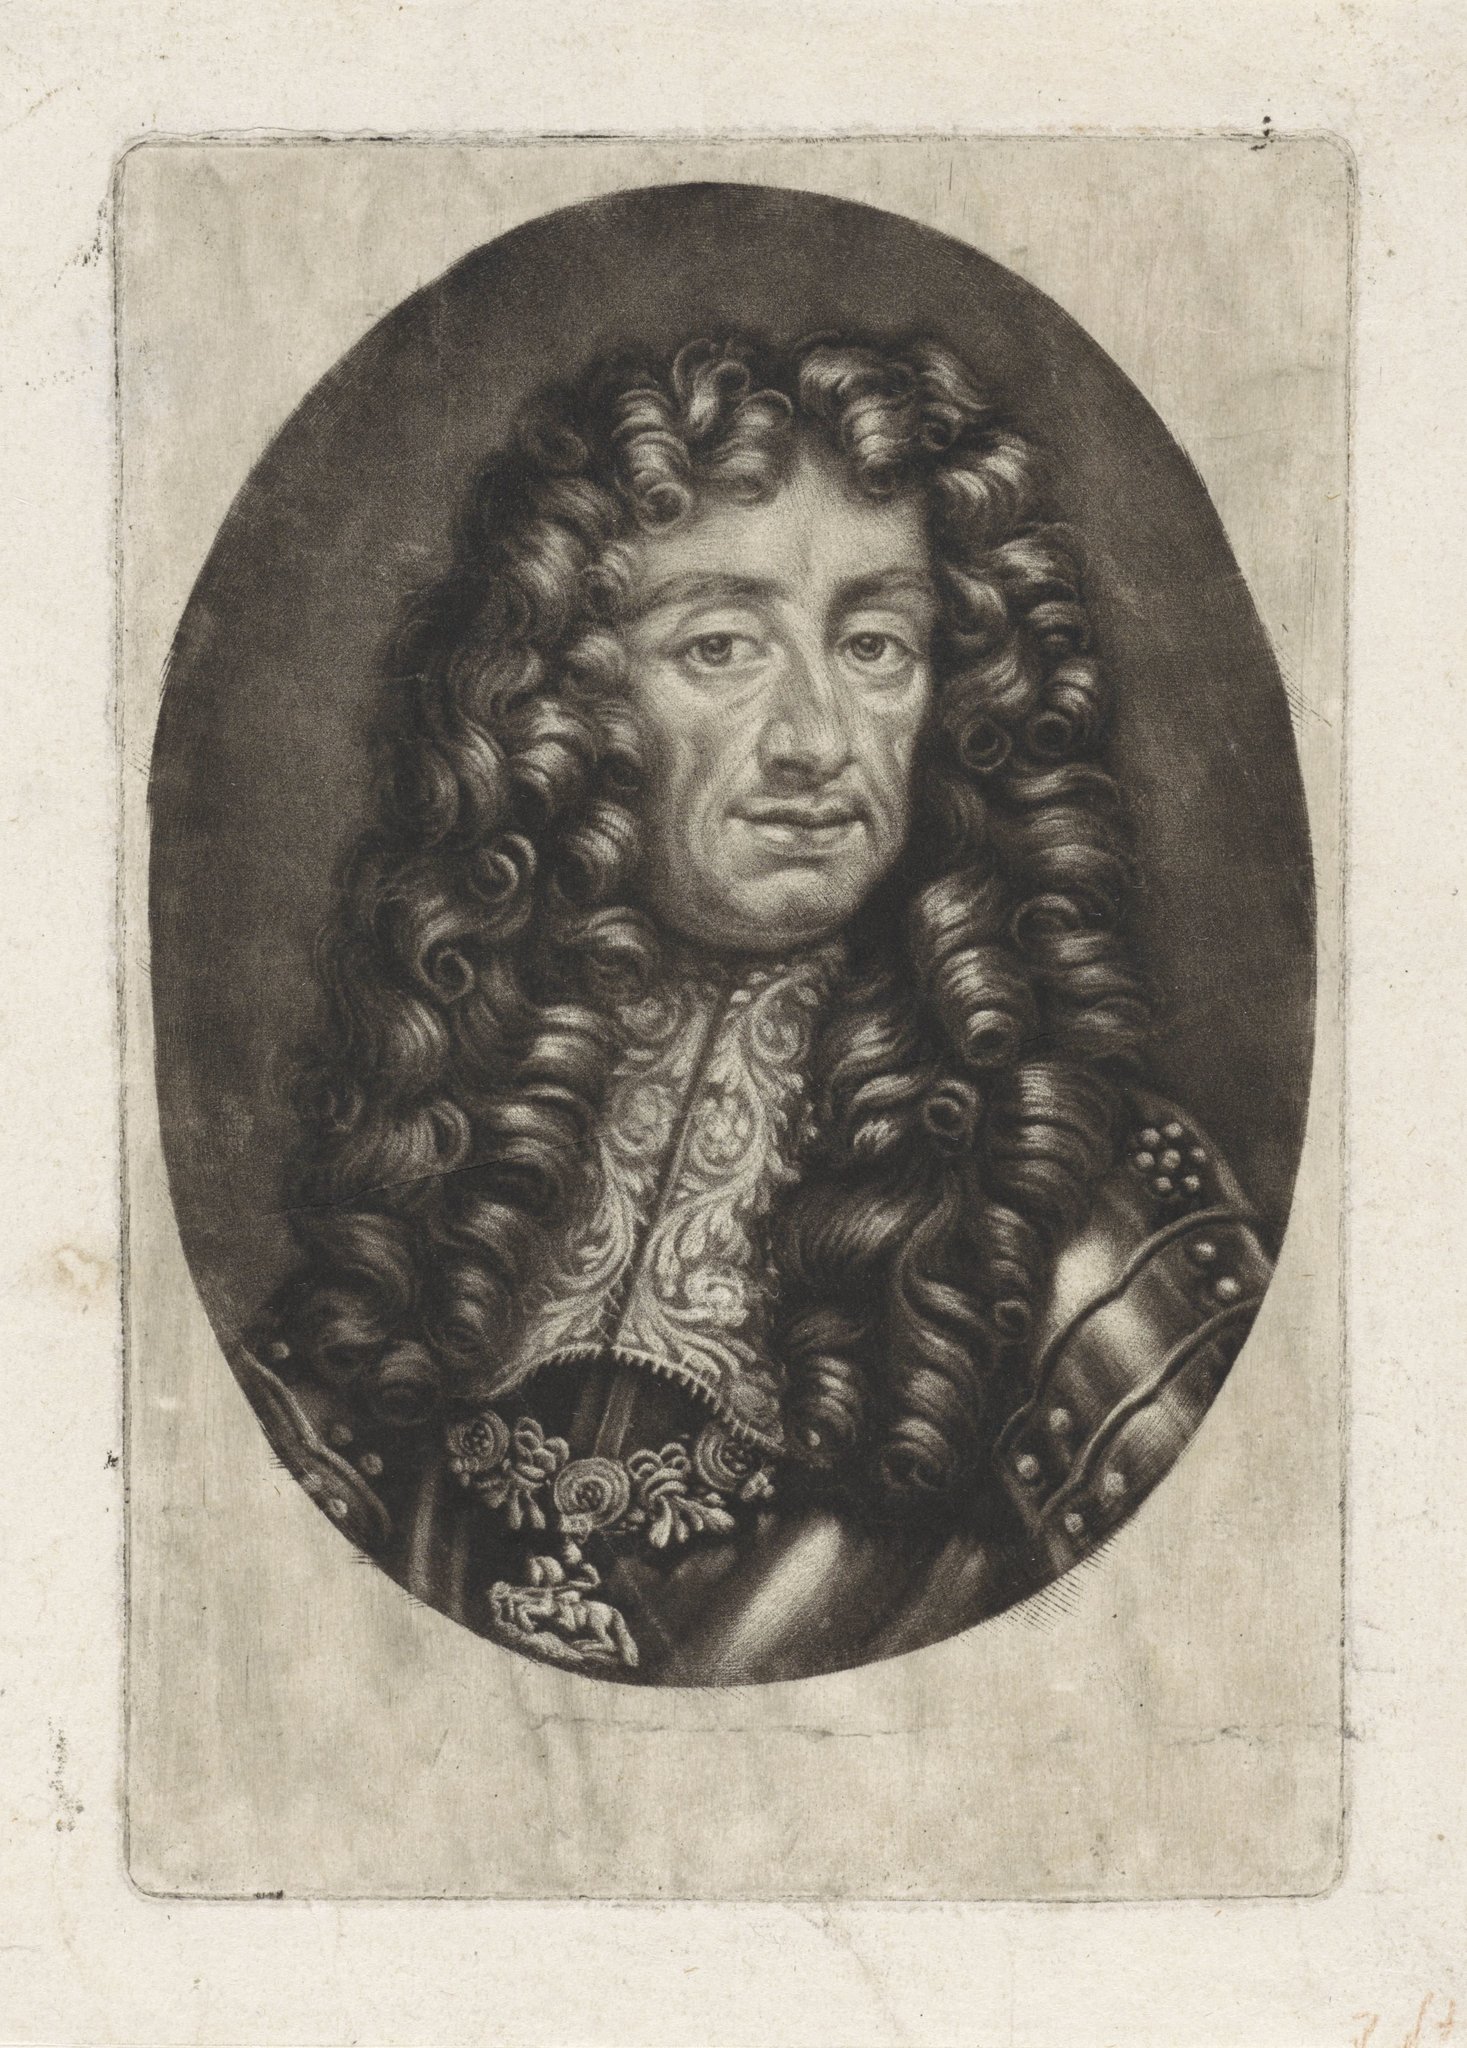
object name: print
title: Portret van een onbekende edelman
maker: gerard valck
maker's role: print maker, publisher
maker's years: 1651-1726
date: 1662-1750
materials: paper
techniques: mezzotint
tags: knighthood order, wig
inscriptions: collector's mark: Lugt 2228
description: Een man met een lange krulpruik, mogelijk een edelman. Om zijn hals een keten waaraan het ordeteken van de Orde van de Kousenband.